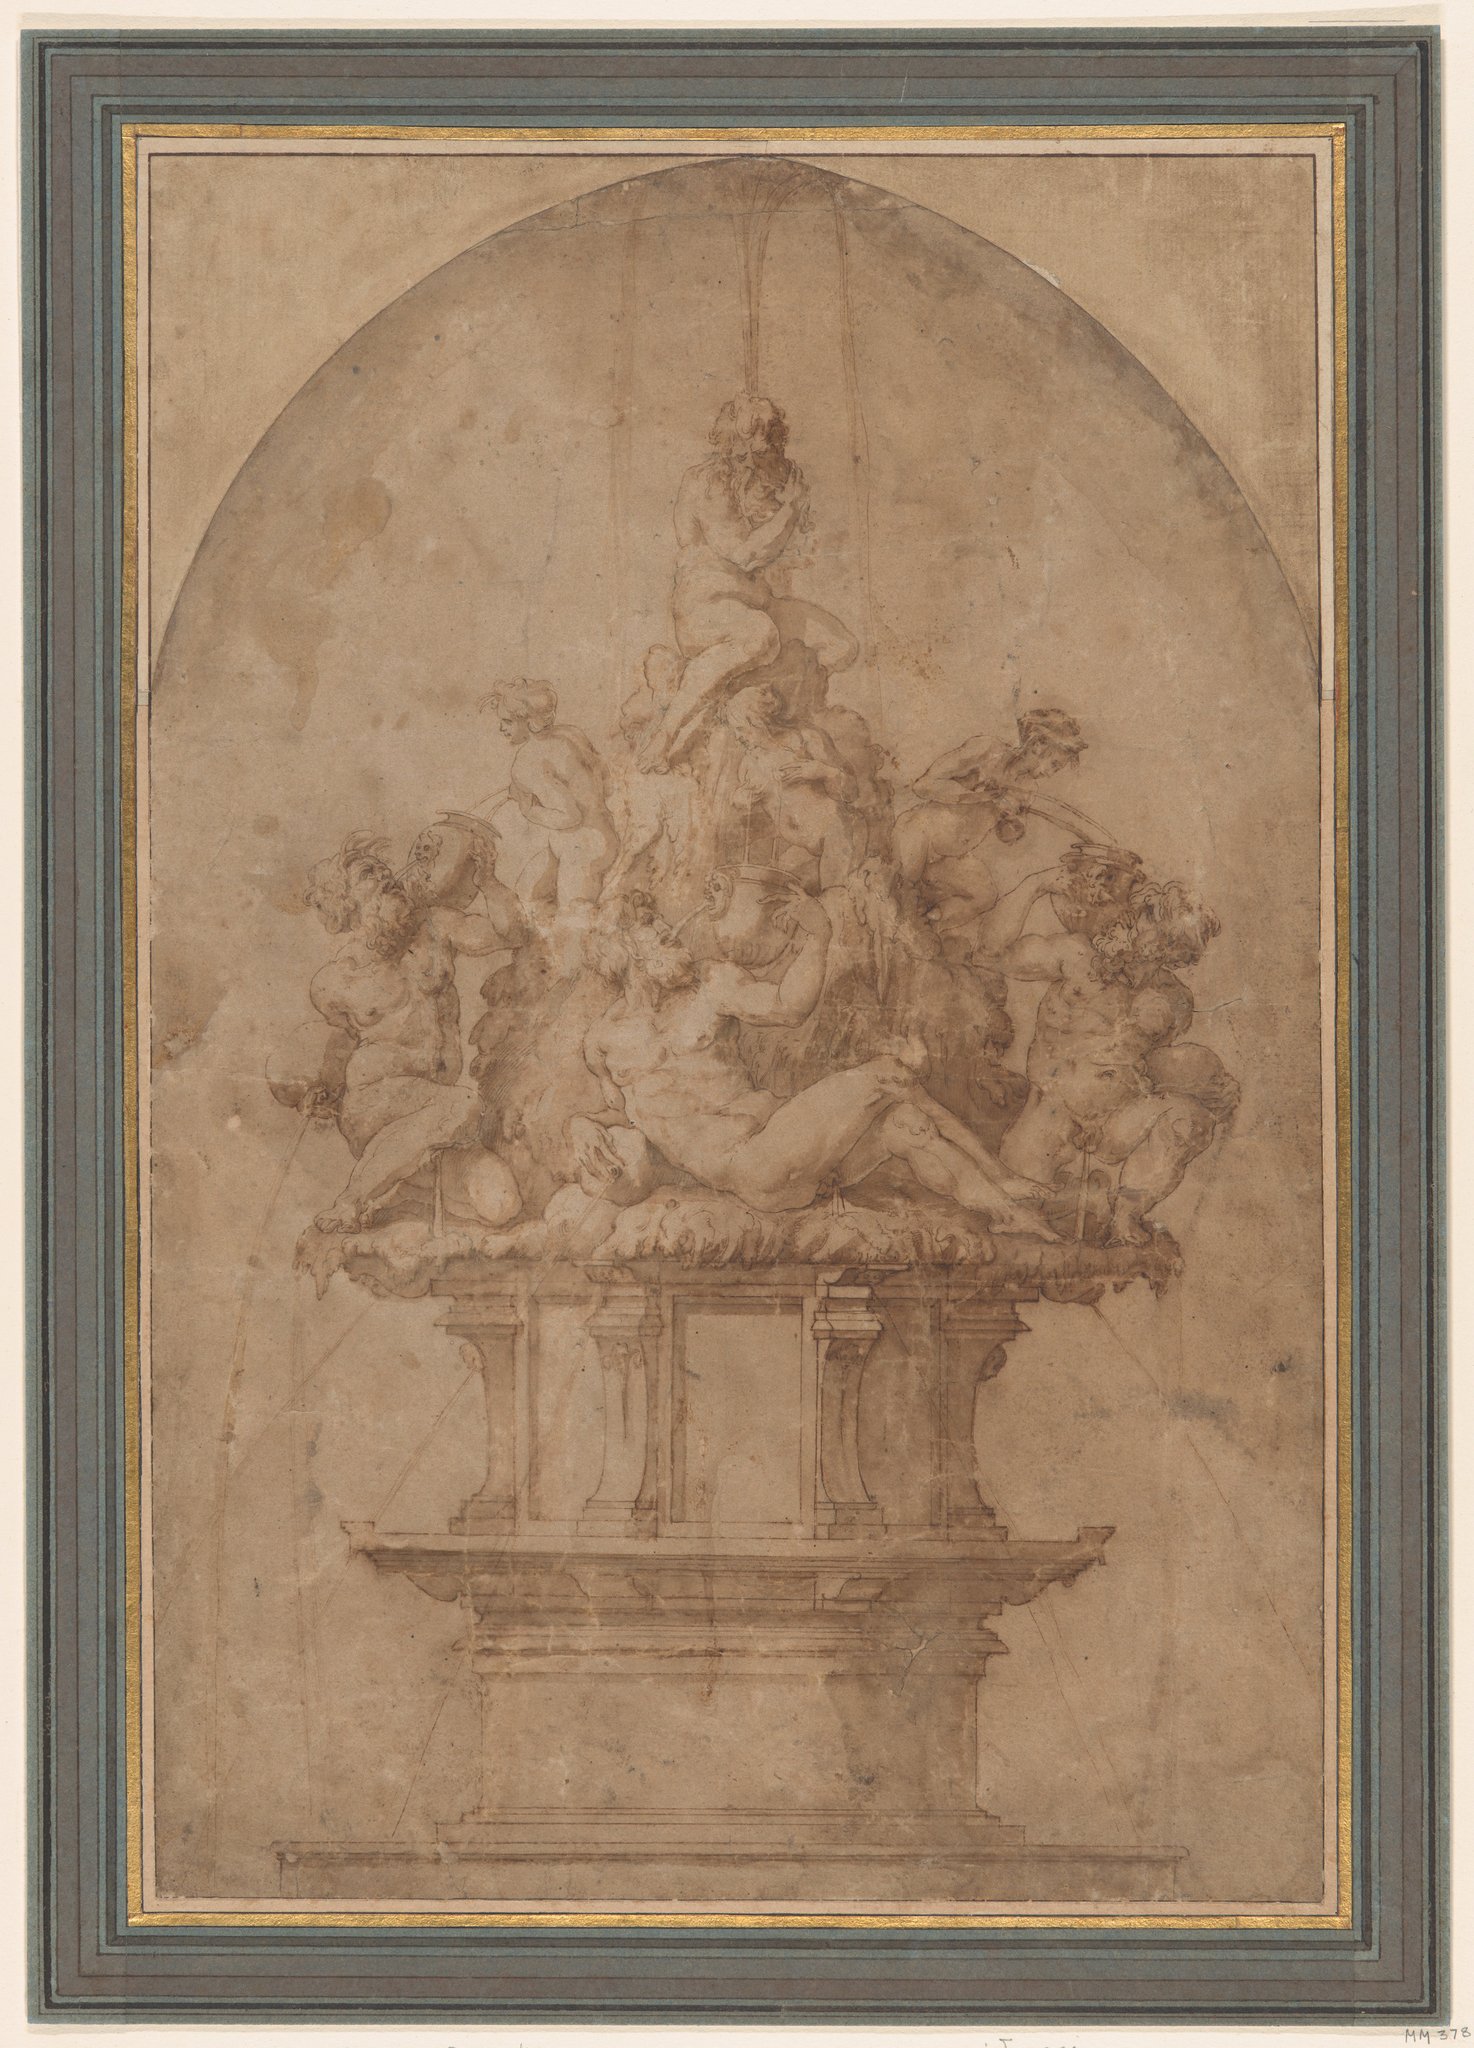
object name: drawing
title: Design for a Fountain with River Gods and Nymphs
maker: giorgio vasari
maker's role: artist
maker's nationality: italian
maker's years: 1511-1574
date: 1511-1574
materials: ink, drawing material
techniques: brush, pen, wash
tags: fountains,male nudes,female nudes,nymphs